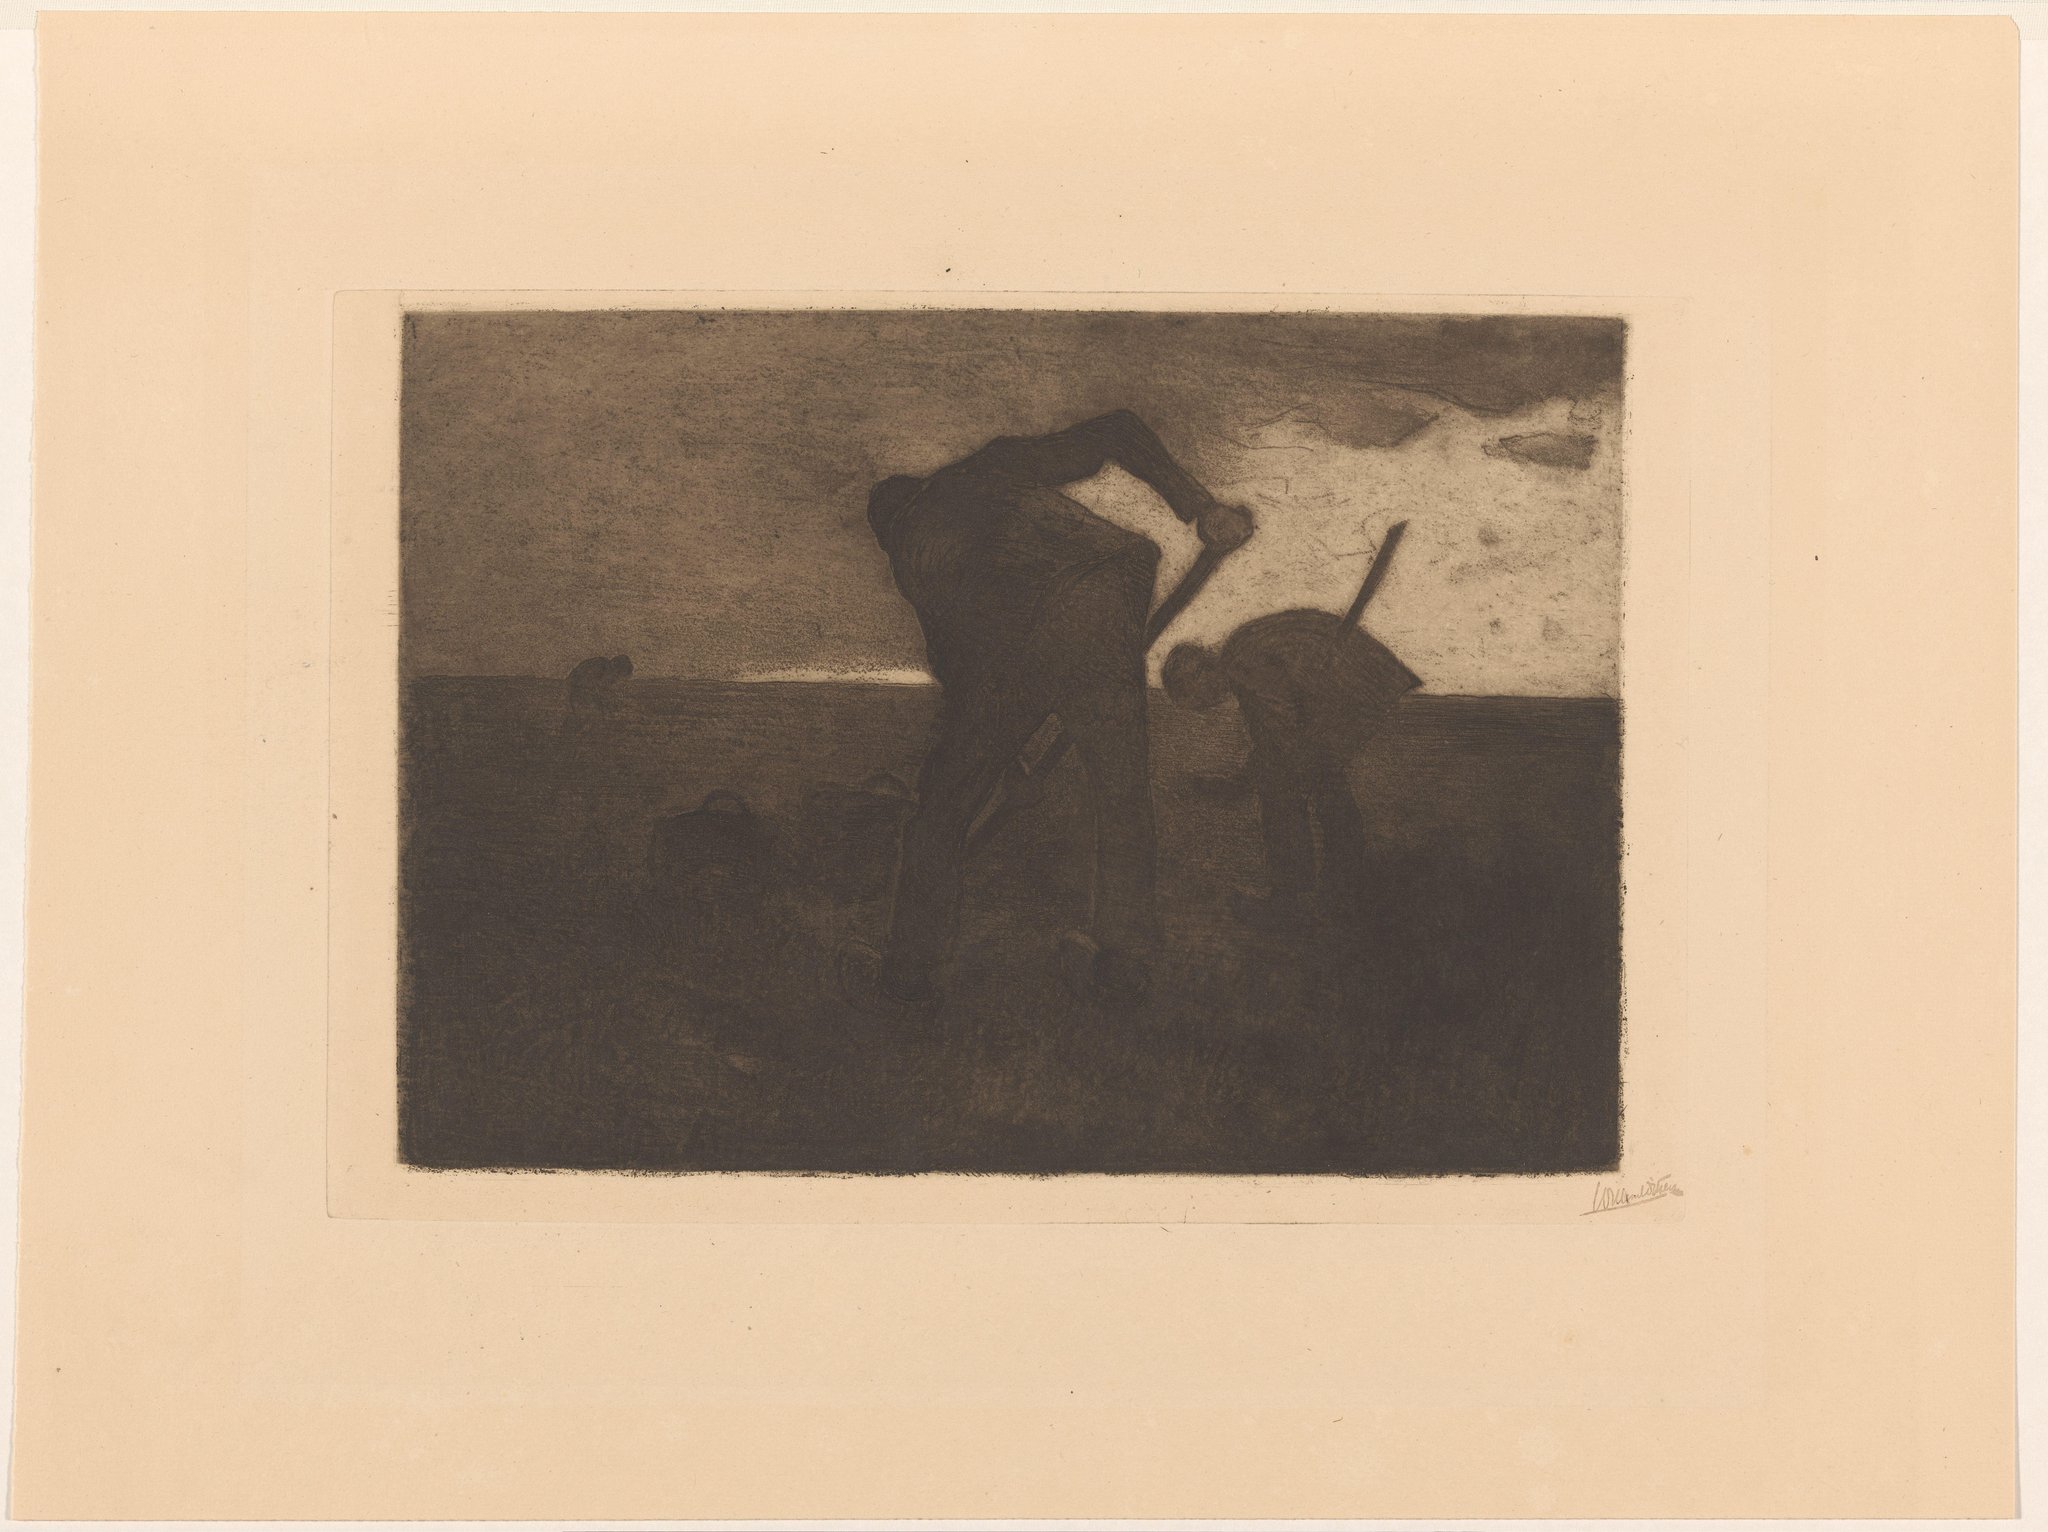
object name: print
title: Drie aardappelrooiers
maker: willem witsen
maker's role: draughtsman, painter, print maker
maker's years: 1860-1923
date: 1887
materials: paper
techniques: etching, intaglio, soft ground etching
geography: ewijkshoeve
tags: harvest, containers, potatoes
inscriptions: collector's mark: Lugt 2228, watermark, signature: ‘Willem Witsen’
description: Twee naar voren gebogen aardappelrooiers met twee manden in de voorgrond. Een derde figuur in de achtergrond.